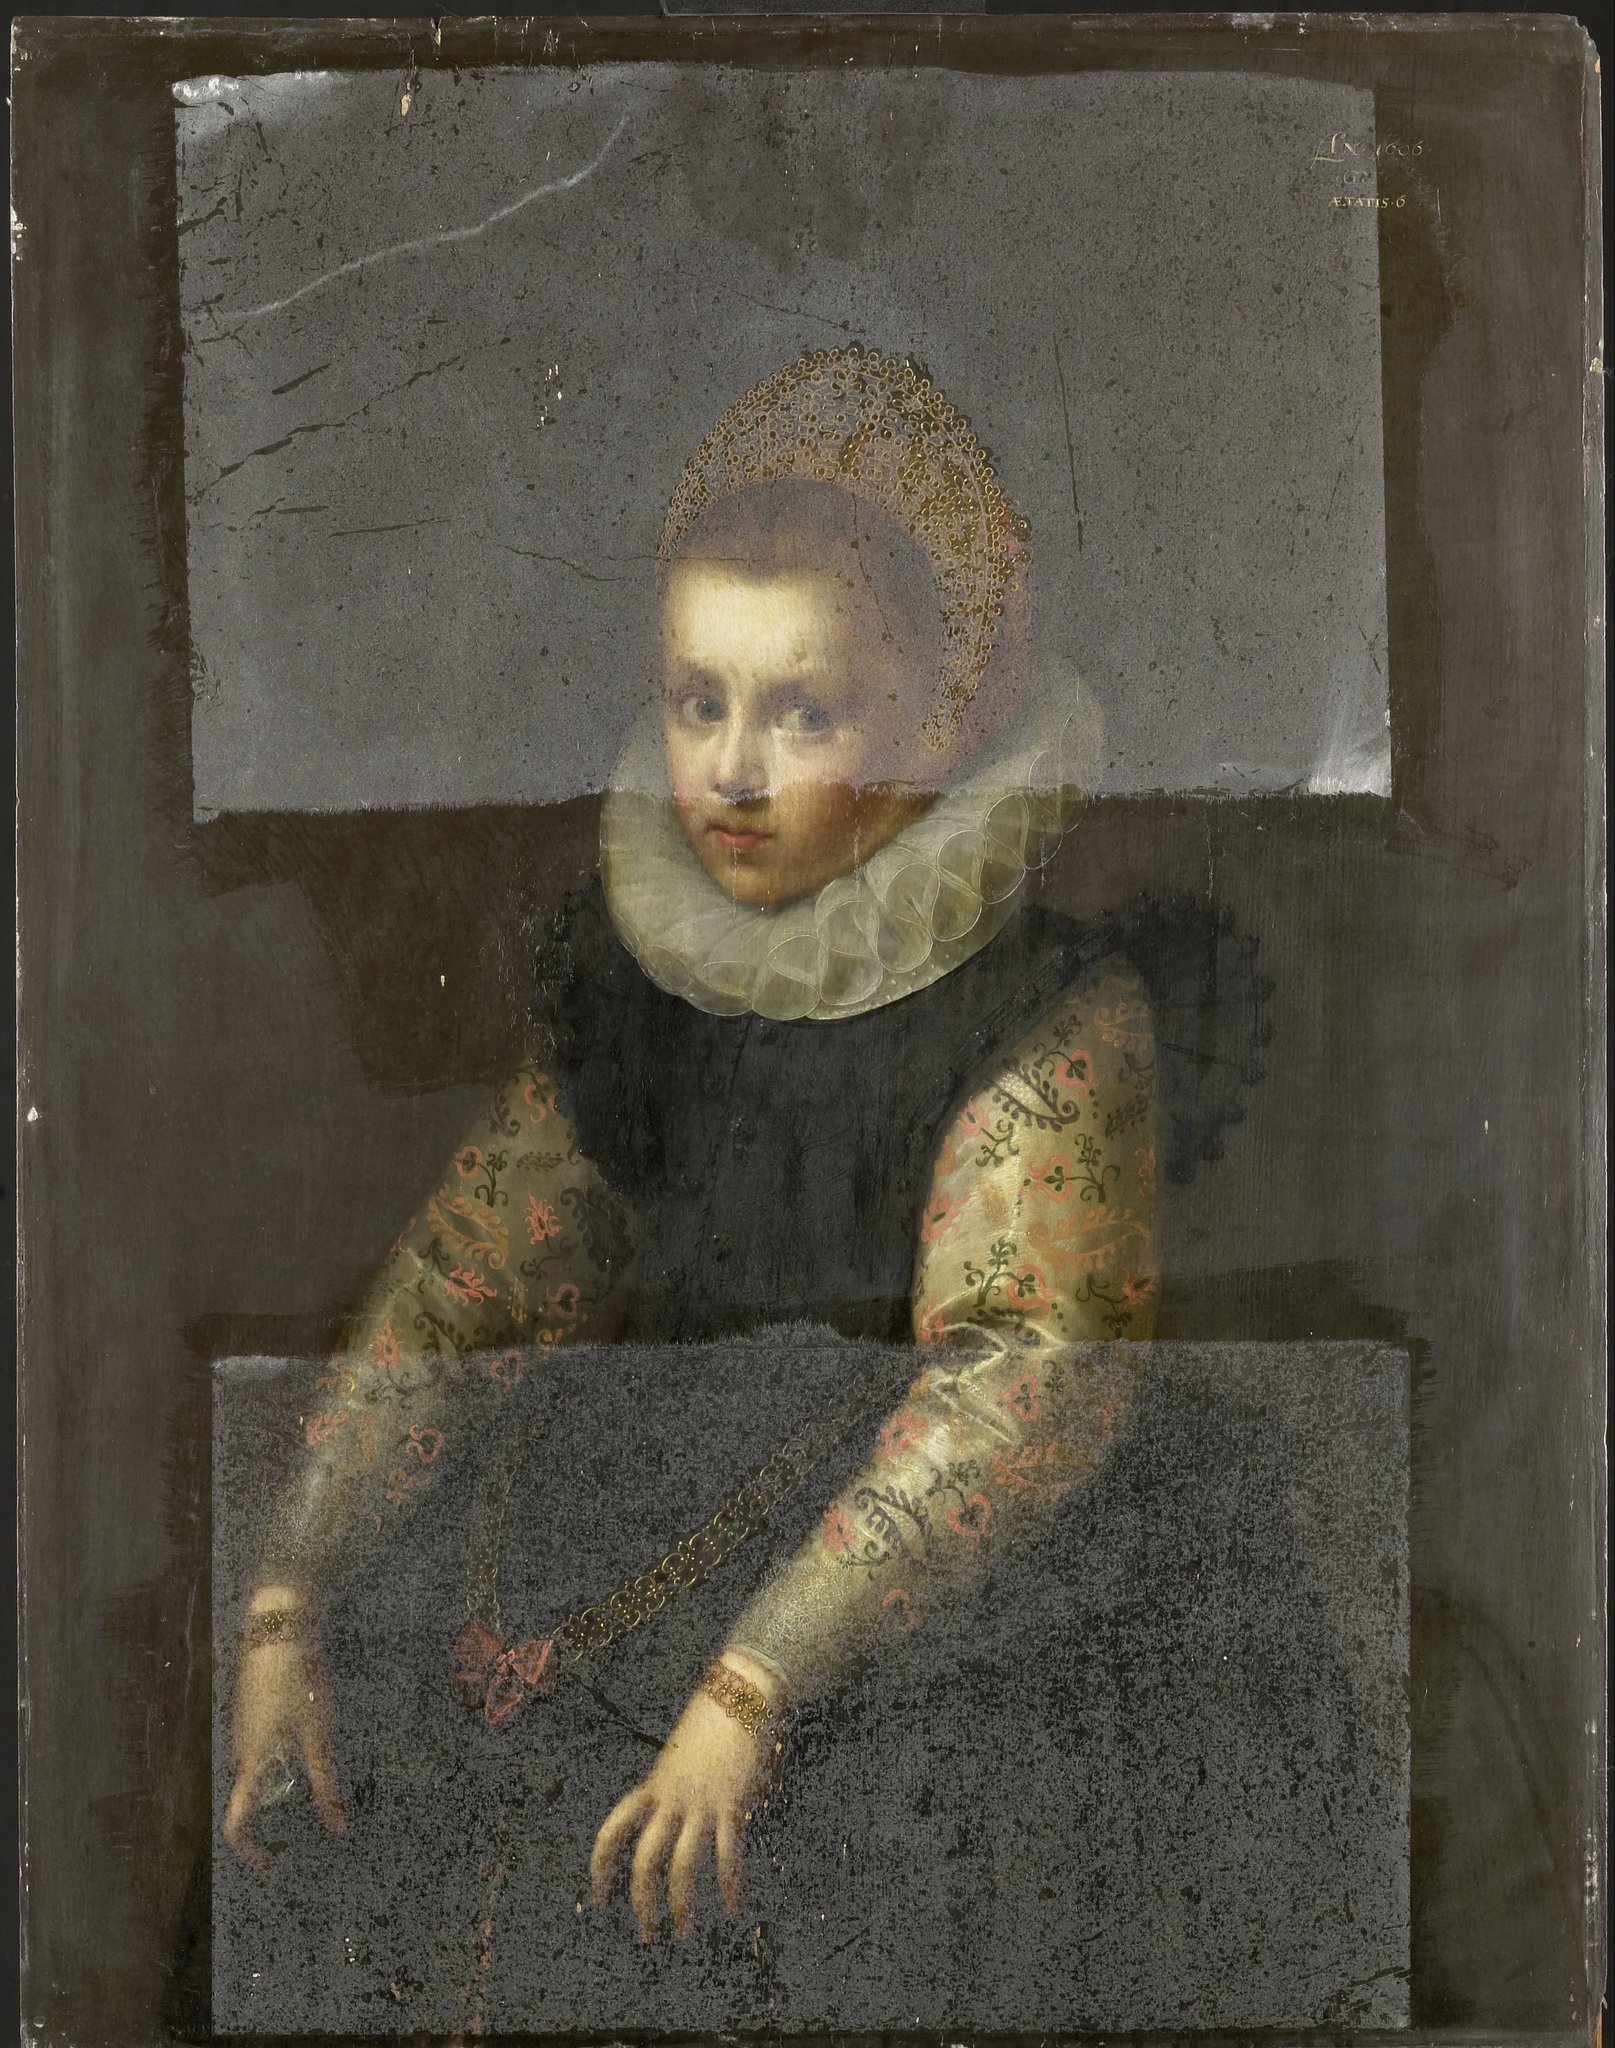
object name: painting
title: A Sister (b. 1600) of Catharina Fourmenois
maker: gortzius geldorp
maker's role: painter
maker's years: 1553-1619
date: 1606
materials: oil, panel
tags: historical persons not known by name - bb - woman, girl (child between toddler and youth)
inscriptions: inscription: ‘Fourmenois. dochter van Jean en Hortenia del Prado Geb: 1600 Overl: / 33’, signature and date: ‘An 1606 GG.F. Aetatis 6.’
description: Portret van een zuster van Catharina Fourmenois. Heupstuk, staand met een ketting met een strik om de middel. Op de achterkant een inscriptie met de naam, familiewapen en het cijfer 33.